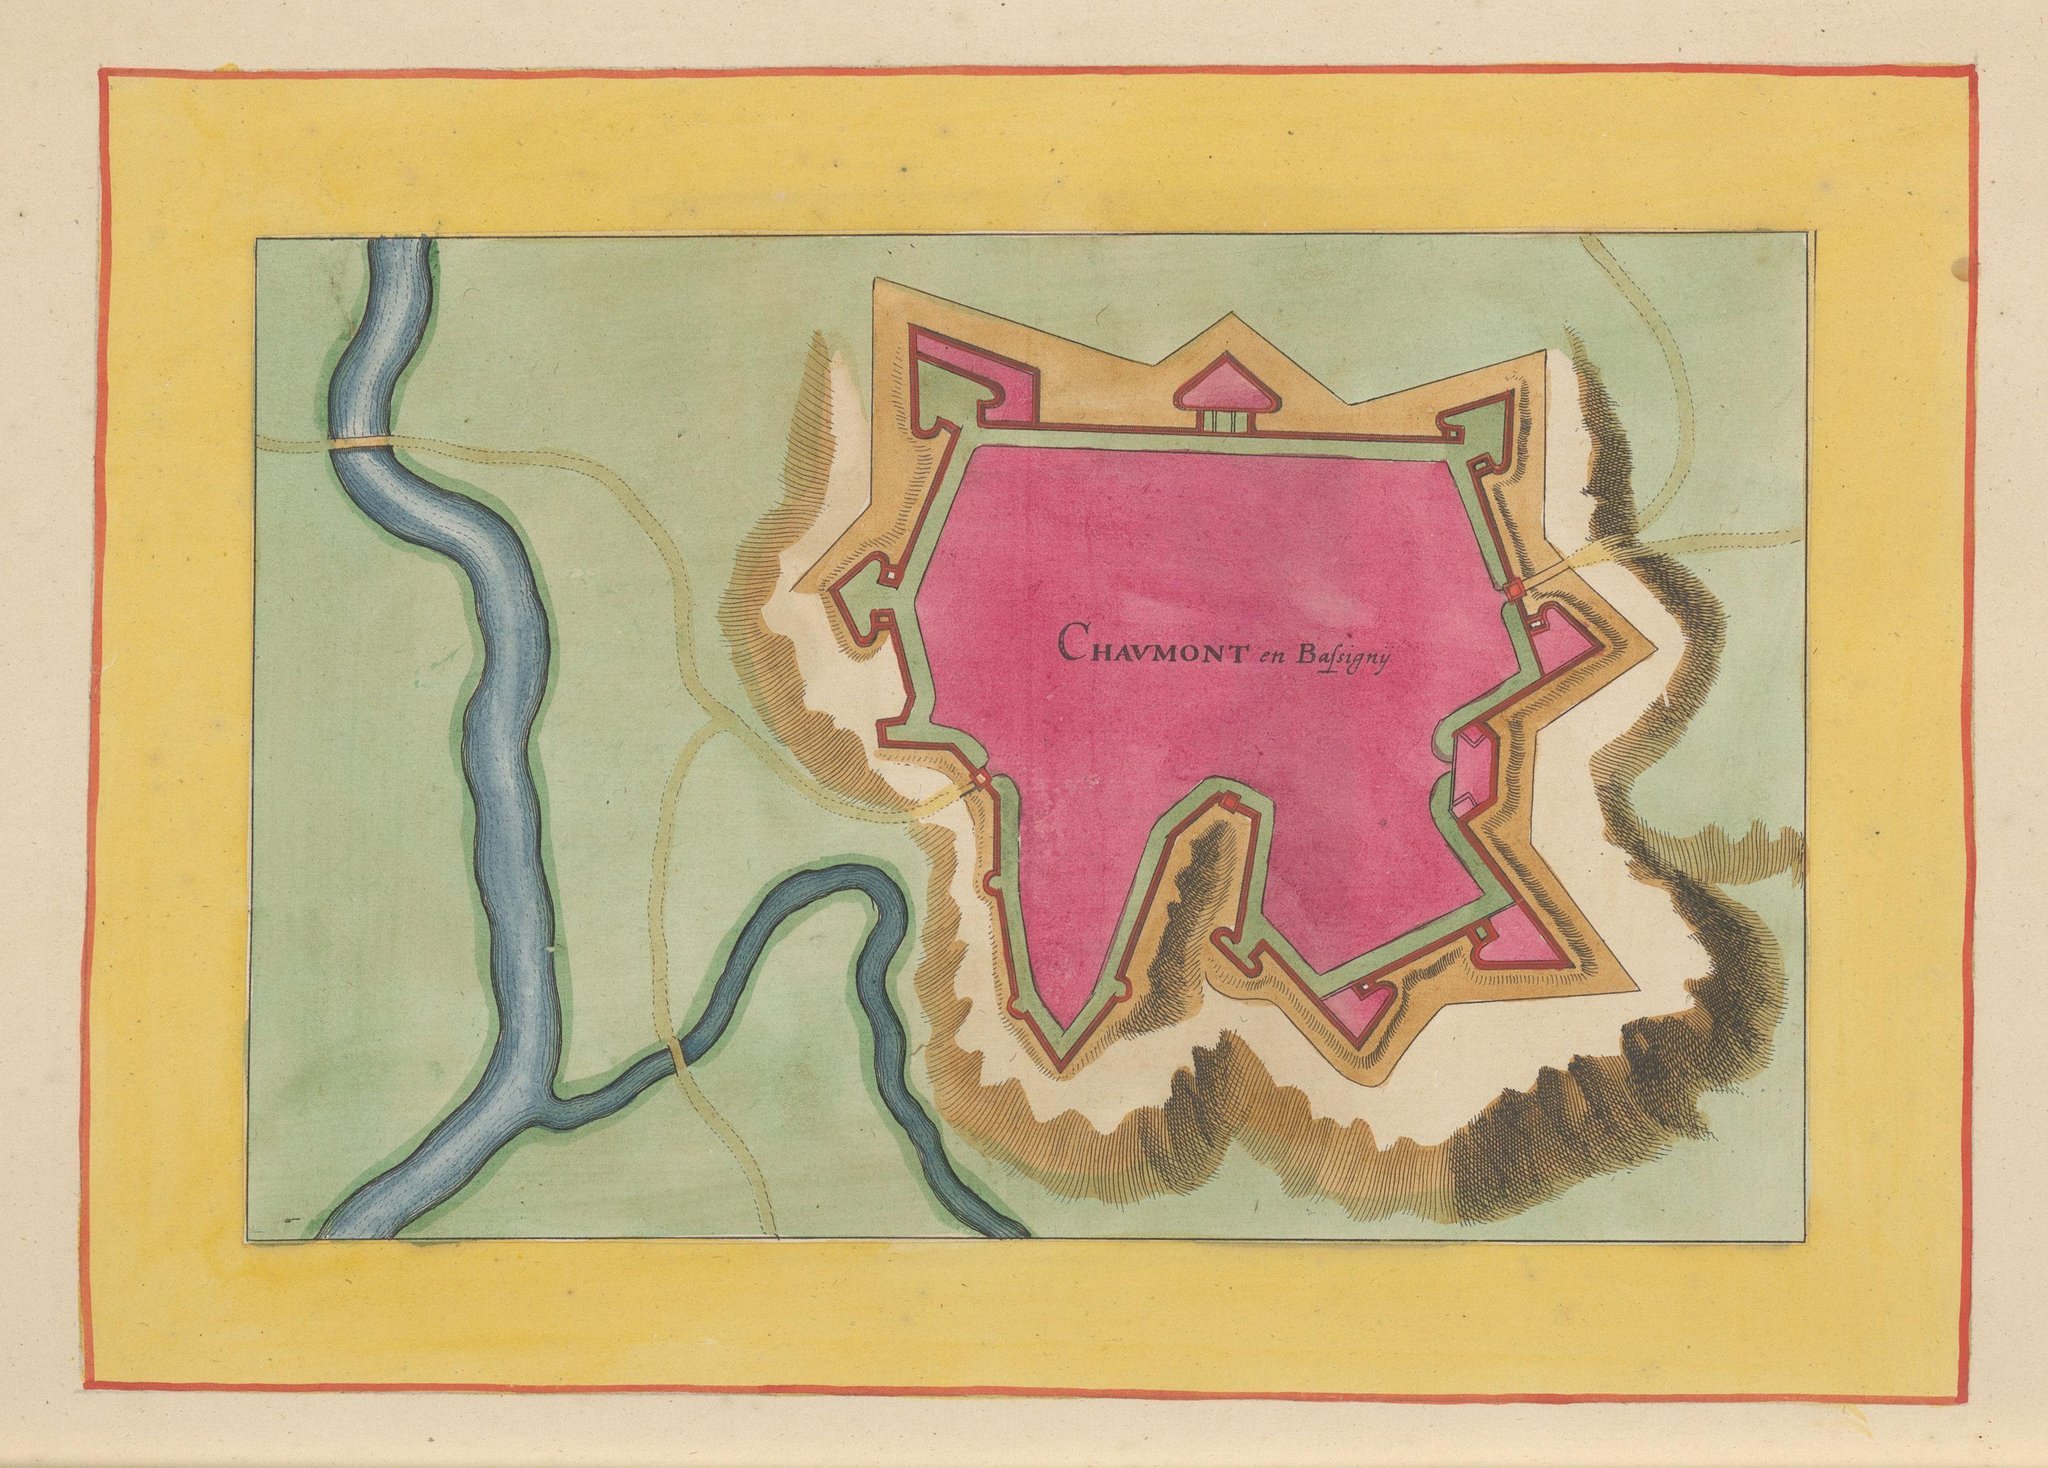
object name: area plan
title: Chaumont en Basigny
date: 1657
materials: paper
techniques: engraving, etching, hand coloring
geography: the hague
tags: maps of cities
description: Prent uit: Zeiller, Martin. Topographia Galliae. 13 dln. Frankfurt: Caspar Merian, 1656, dl. 3, na p. 8.